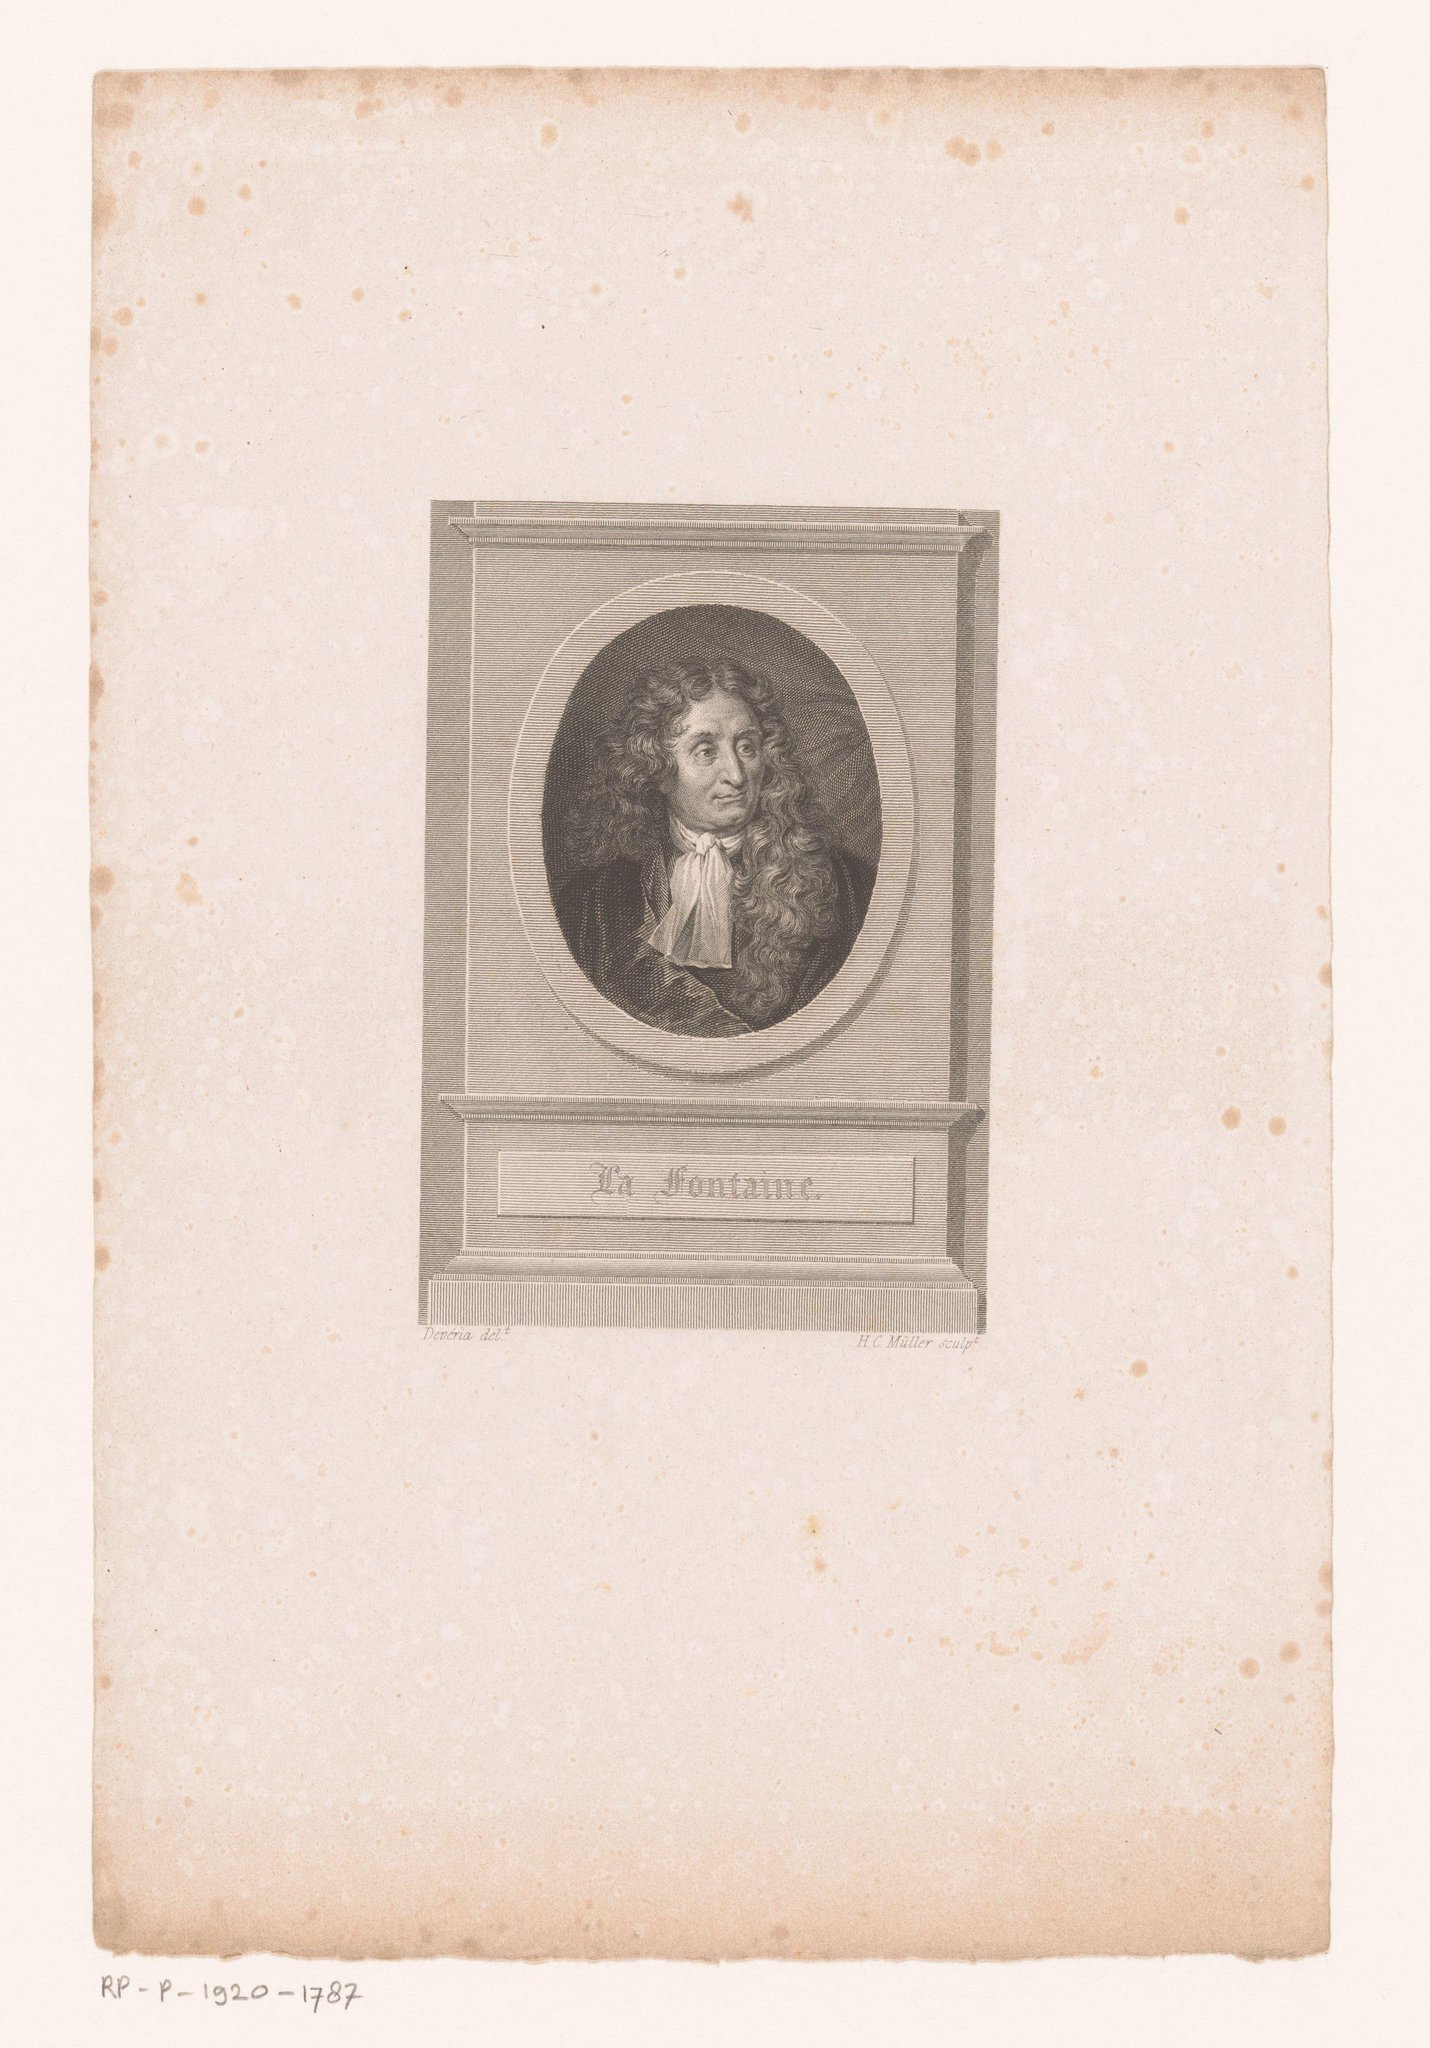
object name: print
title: Portret van Jean de La Fontaine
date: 1820-1846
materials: paper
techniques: engraving, etching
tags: jean de la fontaine, historical persons, portrait of a writer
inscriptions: collector's mark: Lugt 2228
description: Prent uit een onbekende editie van een boek door Jean de La Fontaine.